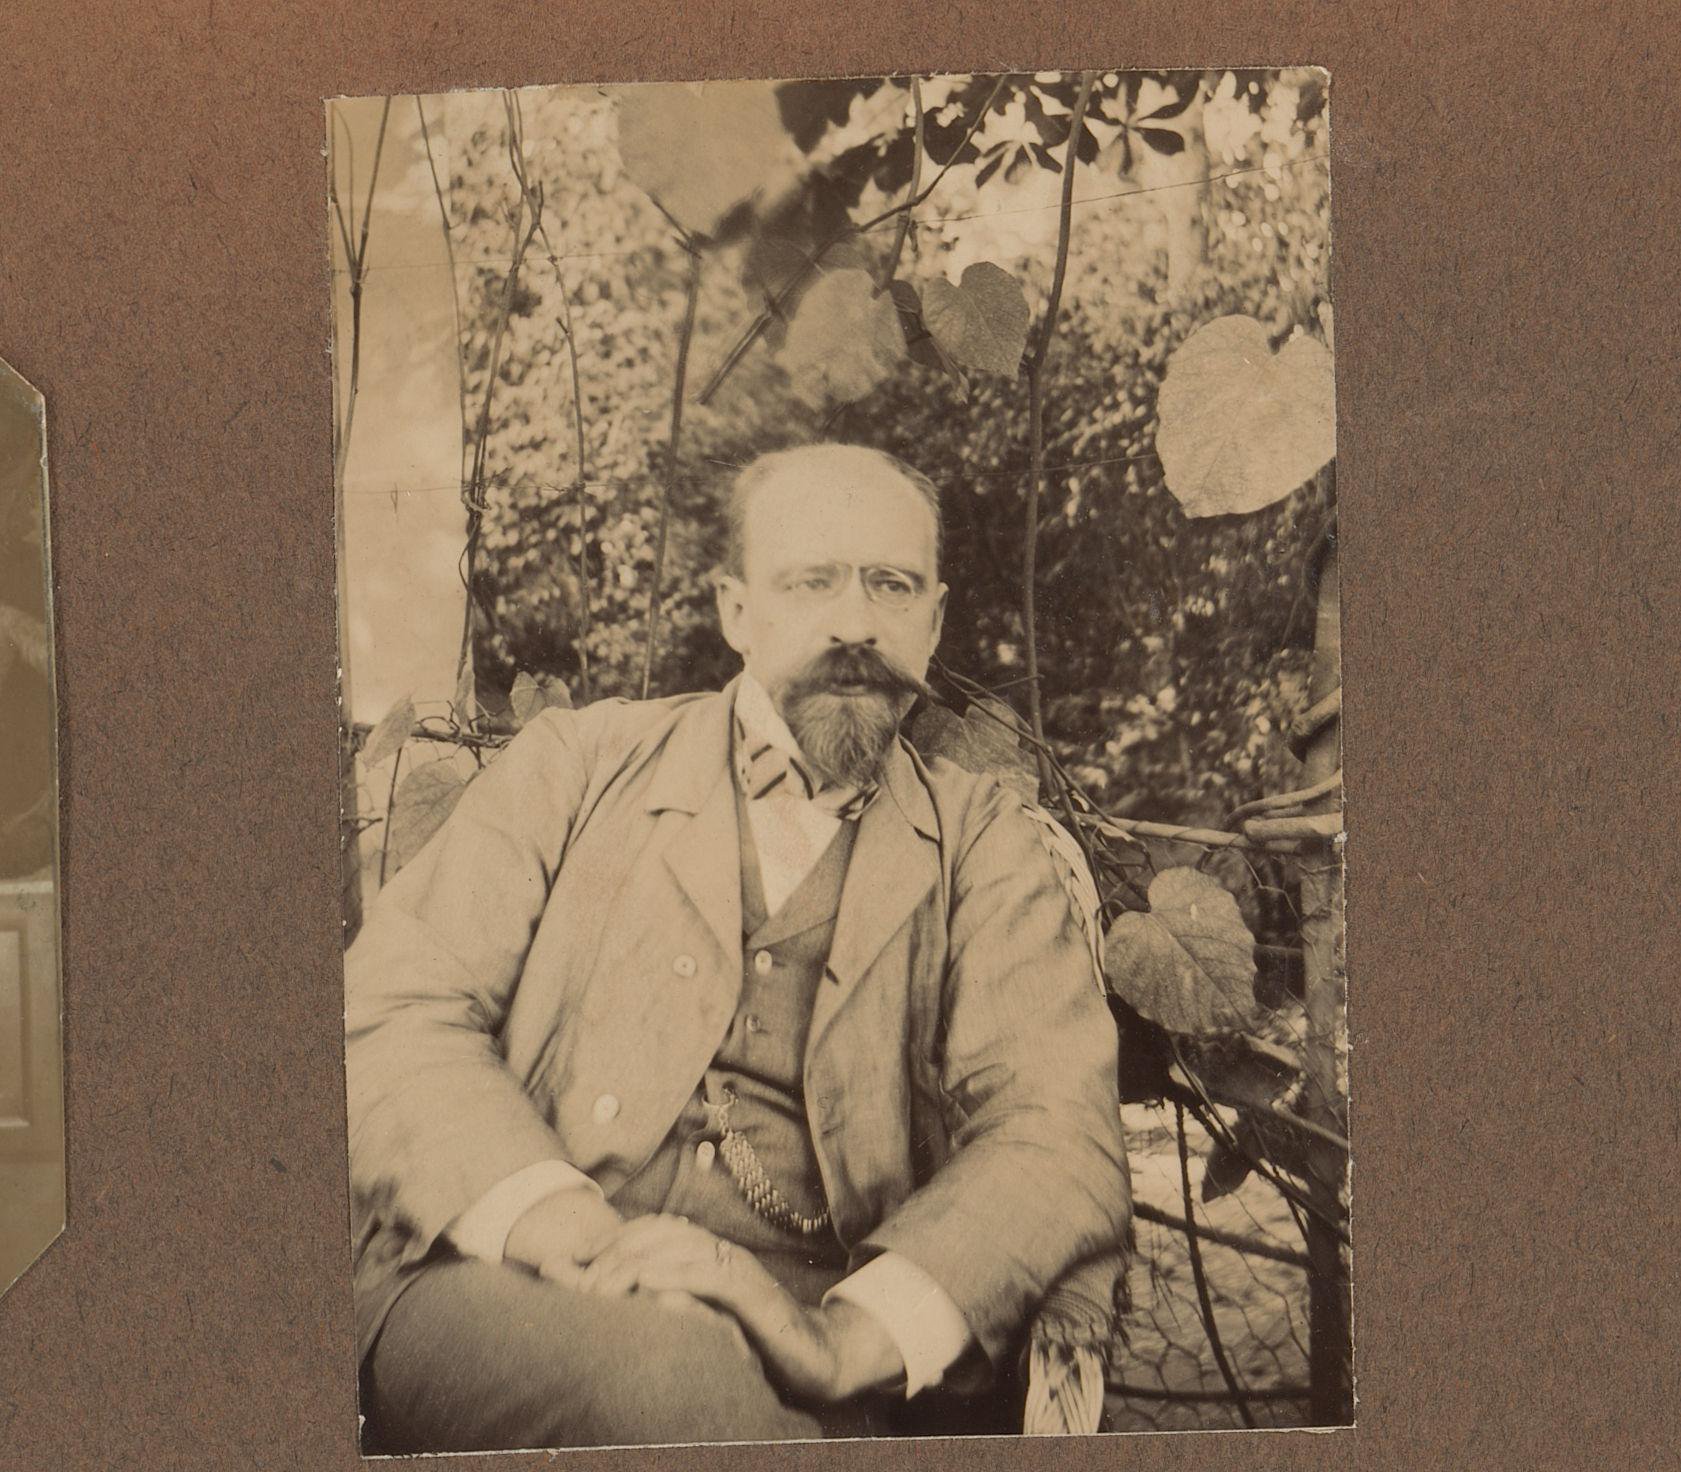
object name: photograph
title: Zittende man met bril en baard in tuin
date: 1870-1920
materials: photographic support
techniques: photography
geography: amsterdam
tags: netherlands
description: Foto op bruin albumblad 35 van familiealbum van Alphons Diepenbrock.